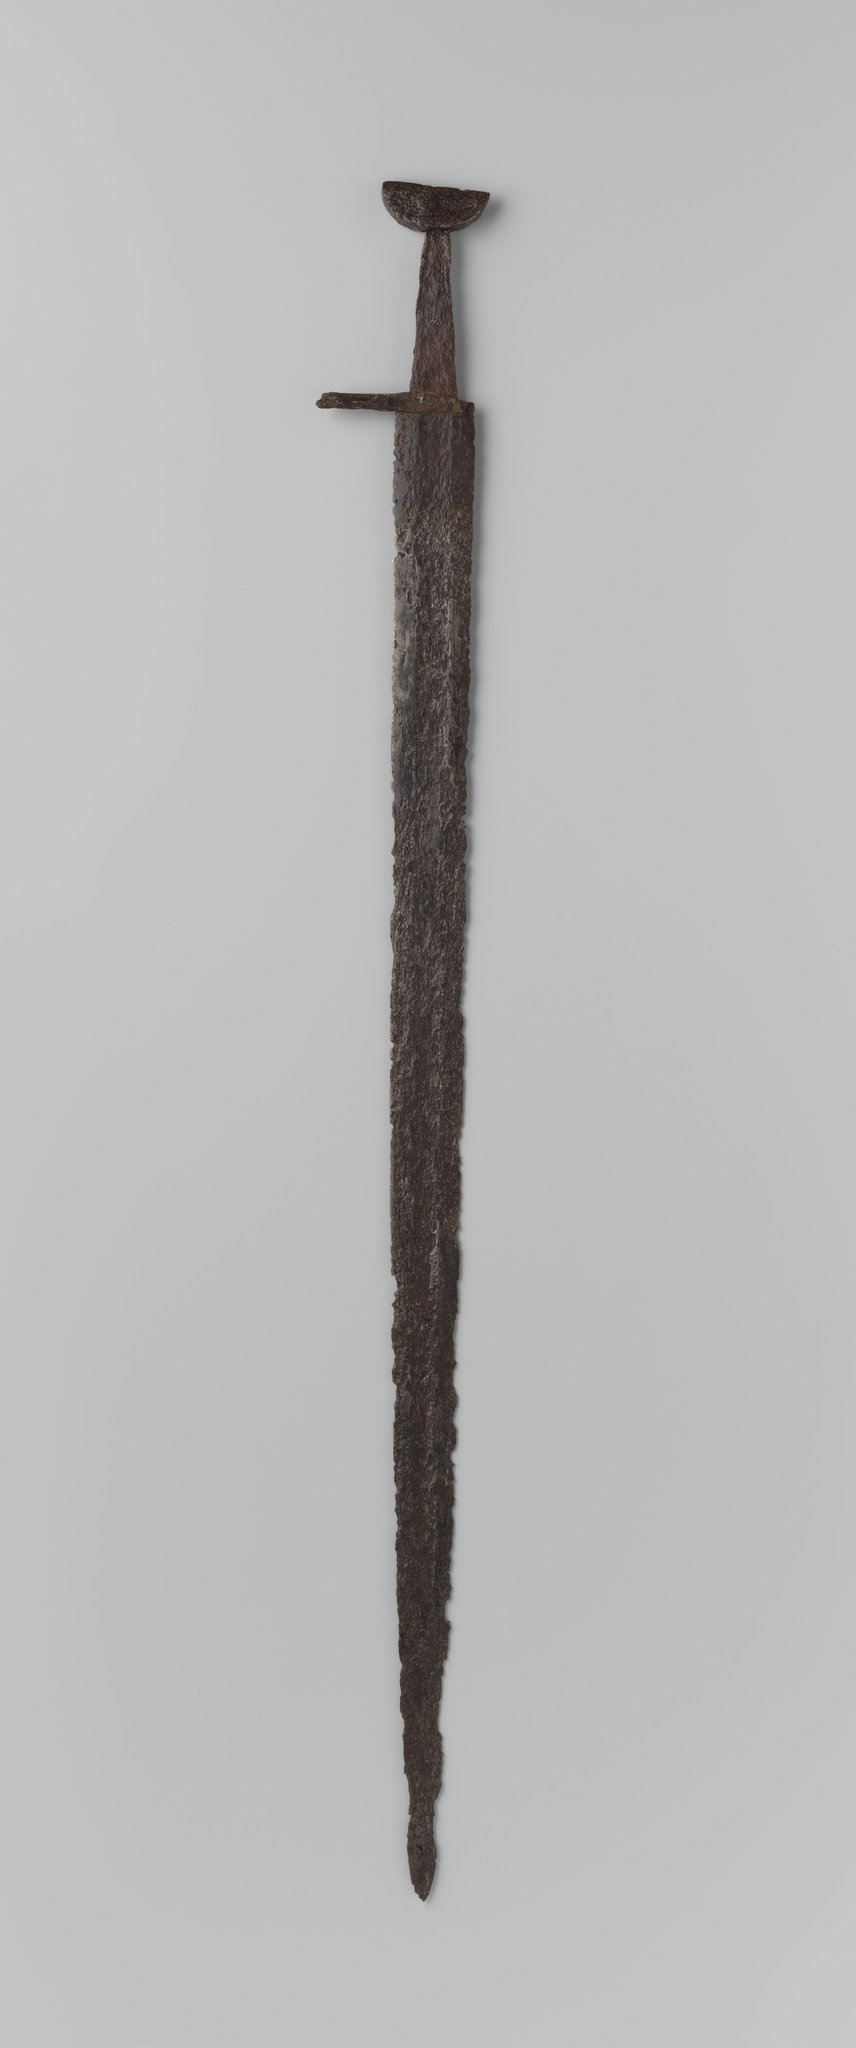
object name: sword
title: IJzeren zwaard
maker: Anonymous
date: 1000-1100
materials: iron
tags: netherlands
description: IJzeren zwaard, tweesnijdend. De greep, welke de omwoeling mist, heeft een platte half cirkelvormige knop en een korte rechte pareerstang. Parreerstang is voor de helft aanwezig. Bloedgeul over bijna de gehele lengte van de kling.